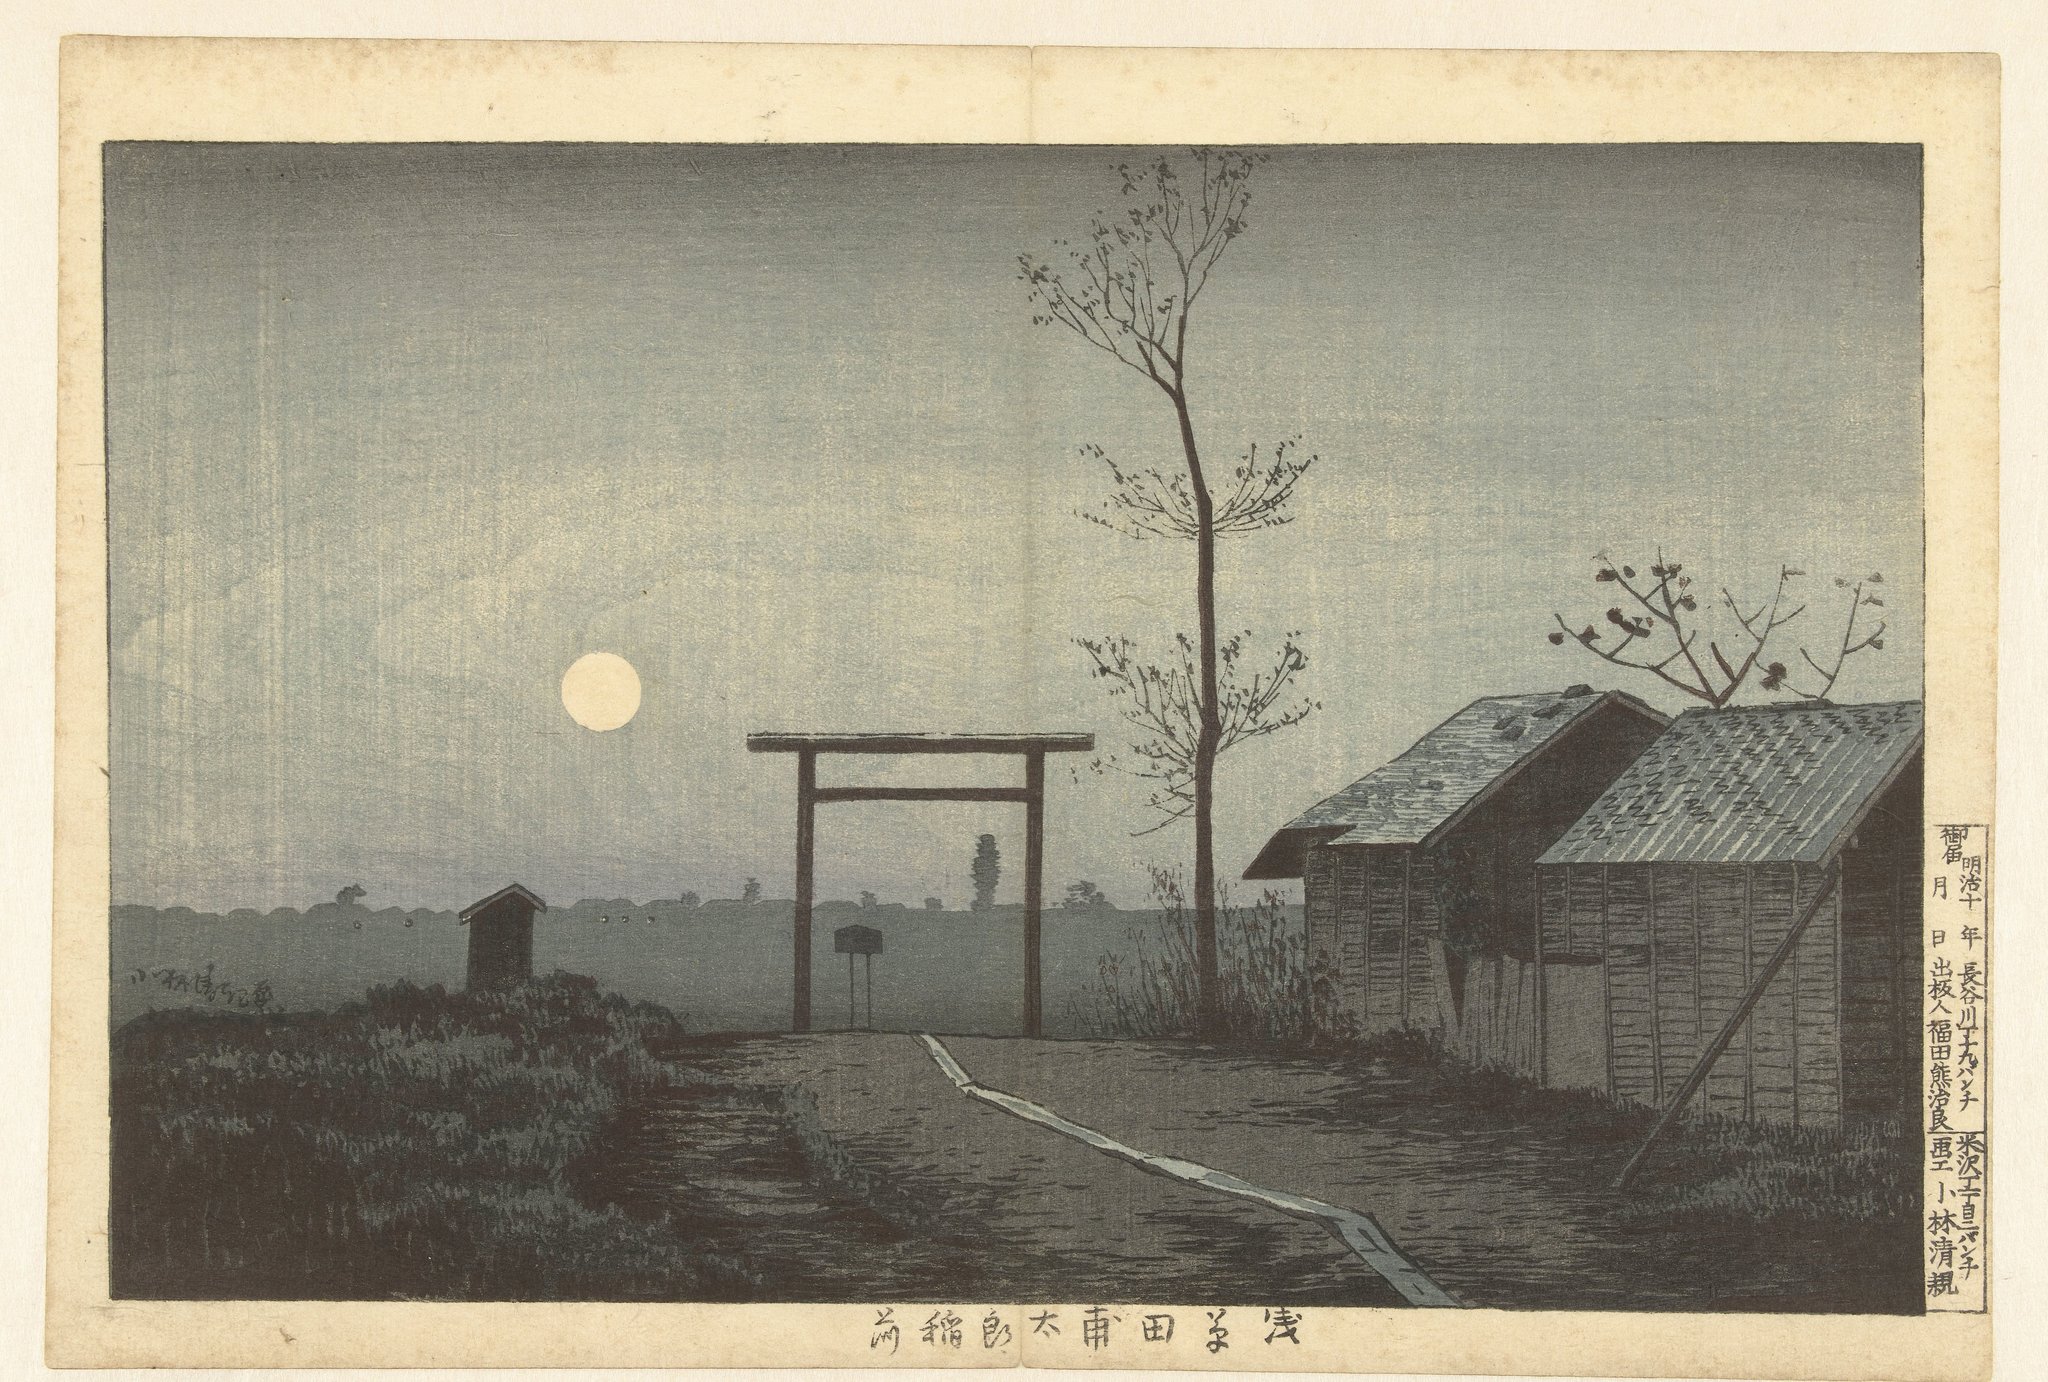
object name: print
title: Het Taro Inari heiligdom in de rijstvelden te Asakusa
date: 1877-1882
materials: paper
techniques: woodcut, nishiki e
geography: tokyo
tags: full moon, dusk, evening twilight, sawahs, rice paddies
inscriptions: collector's mark: Lugt 2760, collector's mark: Lugt 2228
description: Avondlandschap met gezicht op een torii (toegangspoort naar een Shinto heiligdom) bij volle maan; rechts houten gebouwtjes, links rijstvelden.